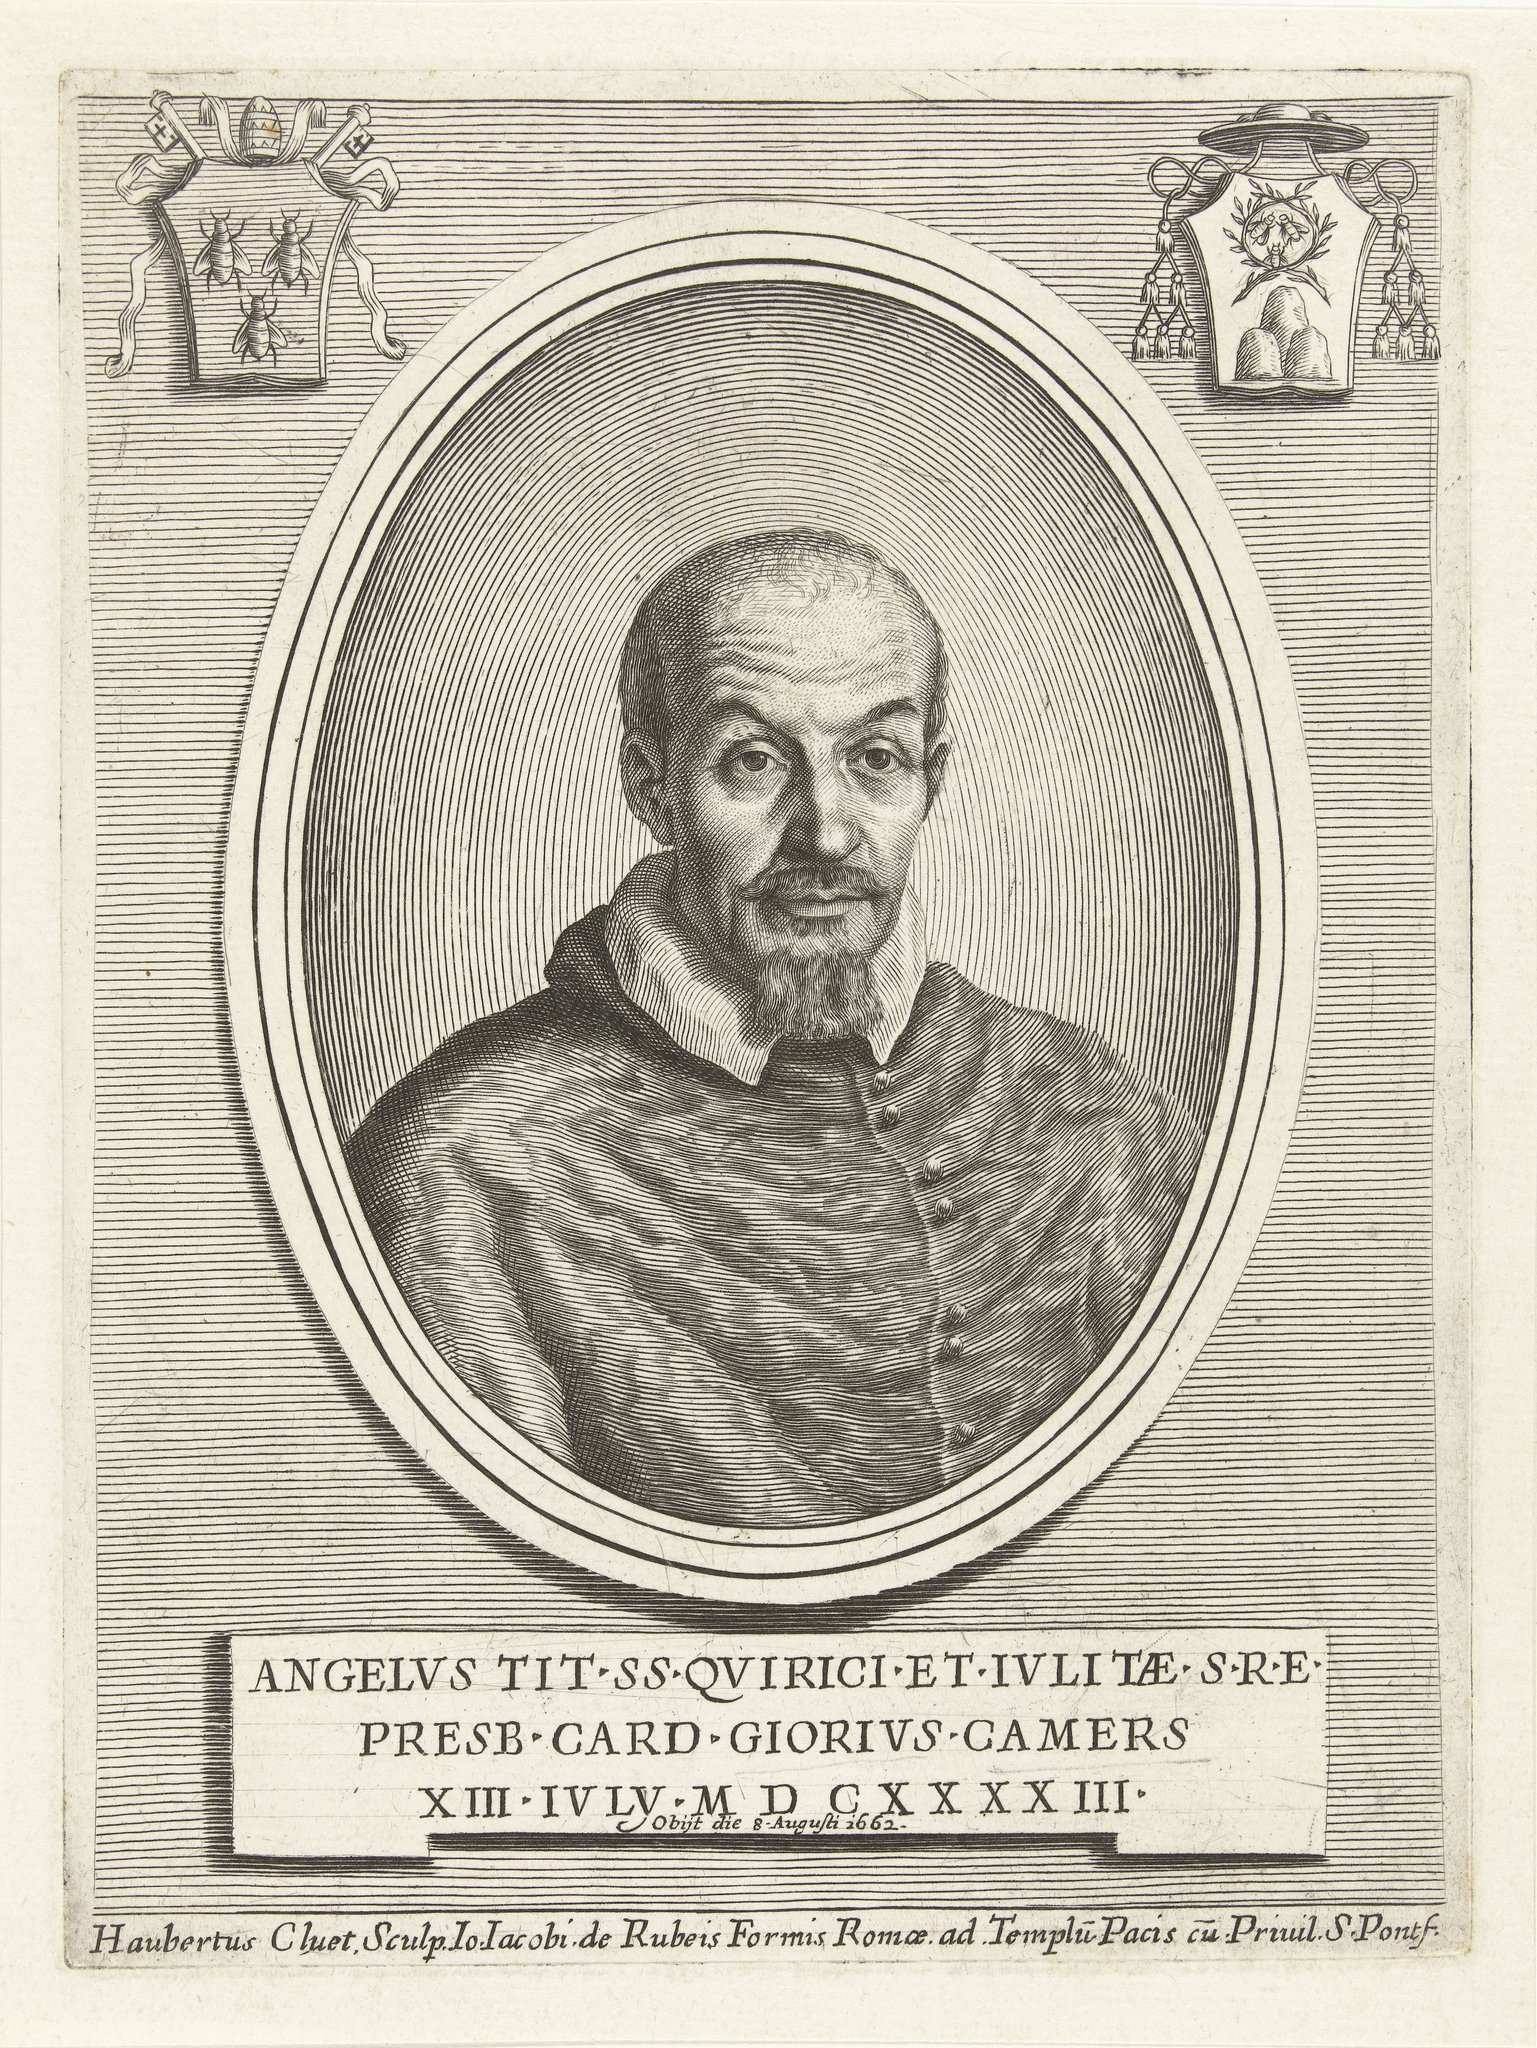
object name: print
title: Effigies cardinalium nunc viventium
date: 1662-1679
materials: paper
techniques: engraving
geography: rome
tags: kardinaal, giori angelo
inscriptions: collector's mark: Lugt 2228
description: Portret in ovale lijst van kardinaal Giori Angelo. Buste frontaal. Bovenaan links het wapen van paus Urbanus VIII, bovenaan rechts het wapen van kardinaal Giori Angelo. De prent heeft een Latijns onderschrift met gegevens over de geportretteerde.